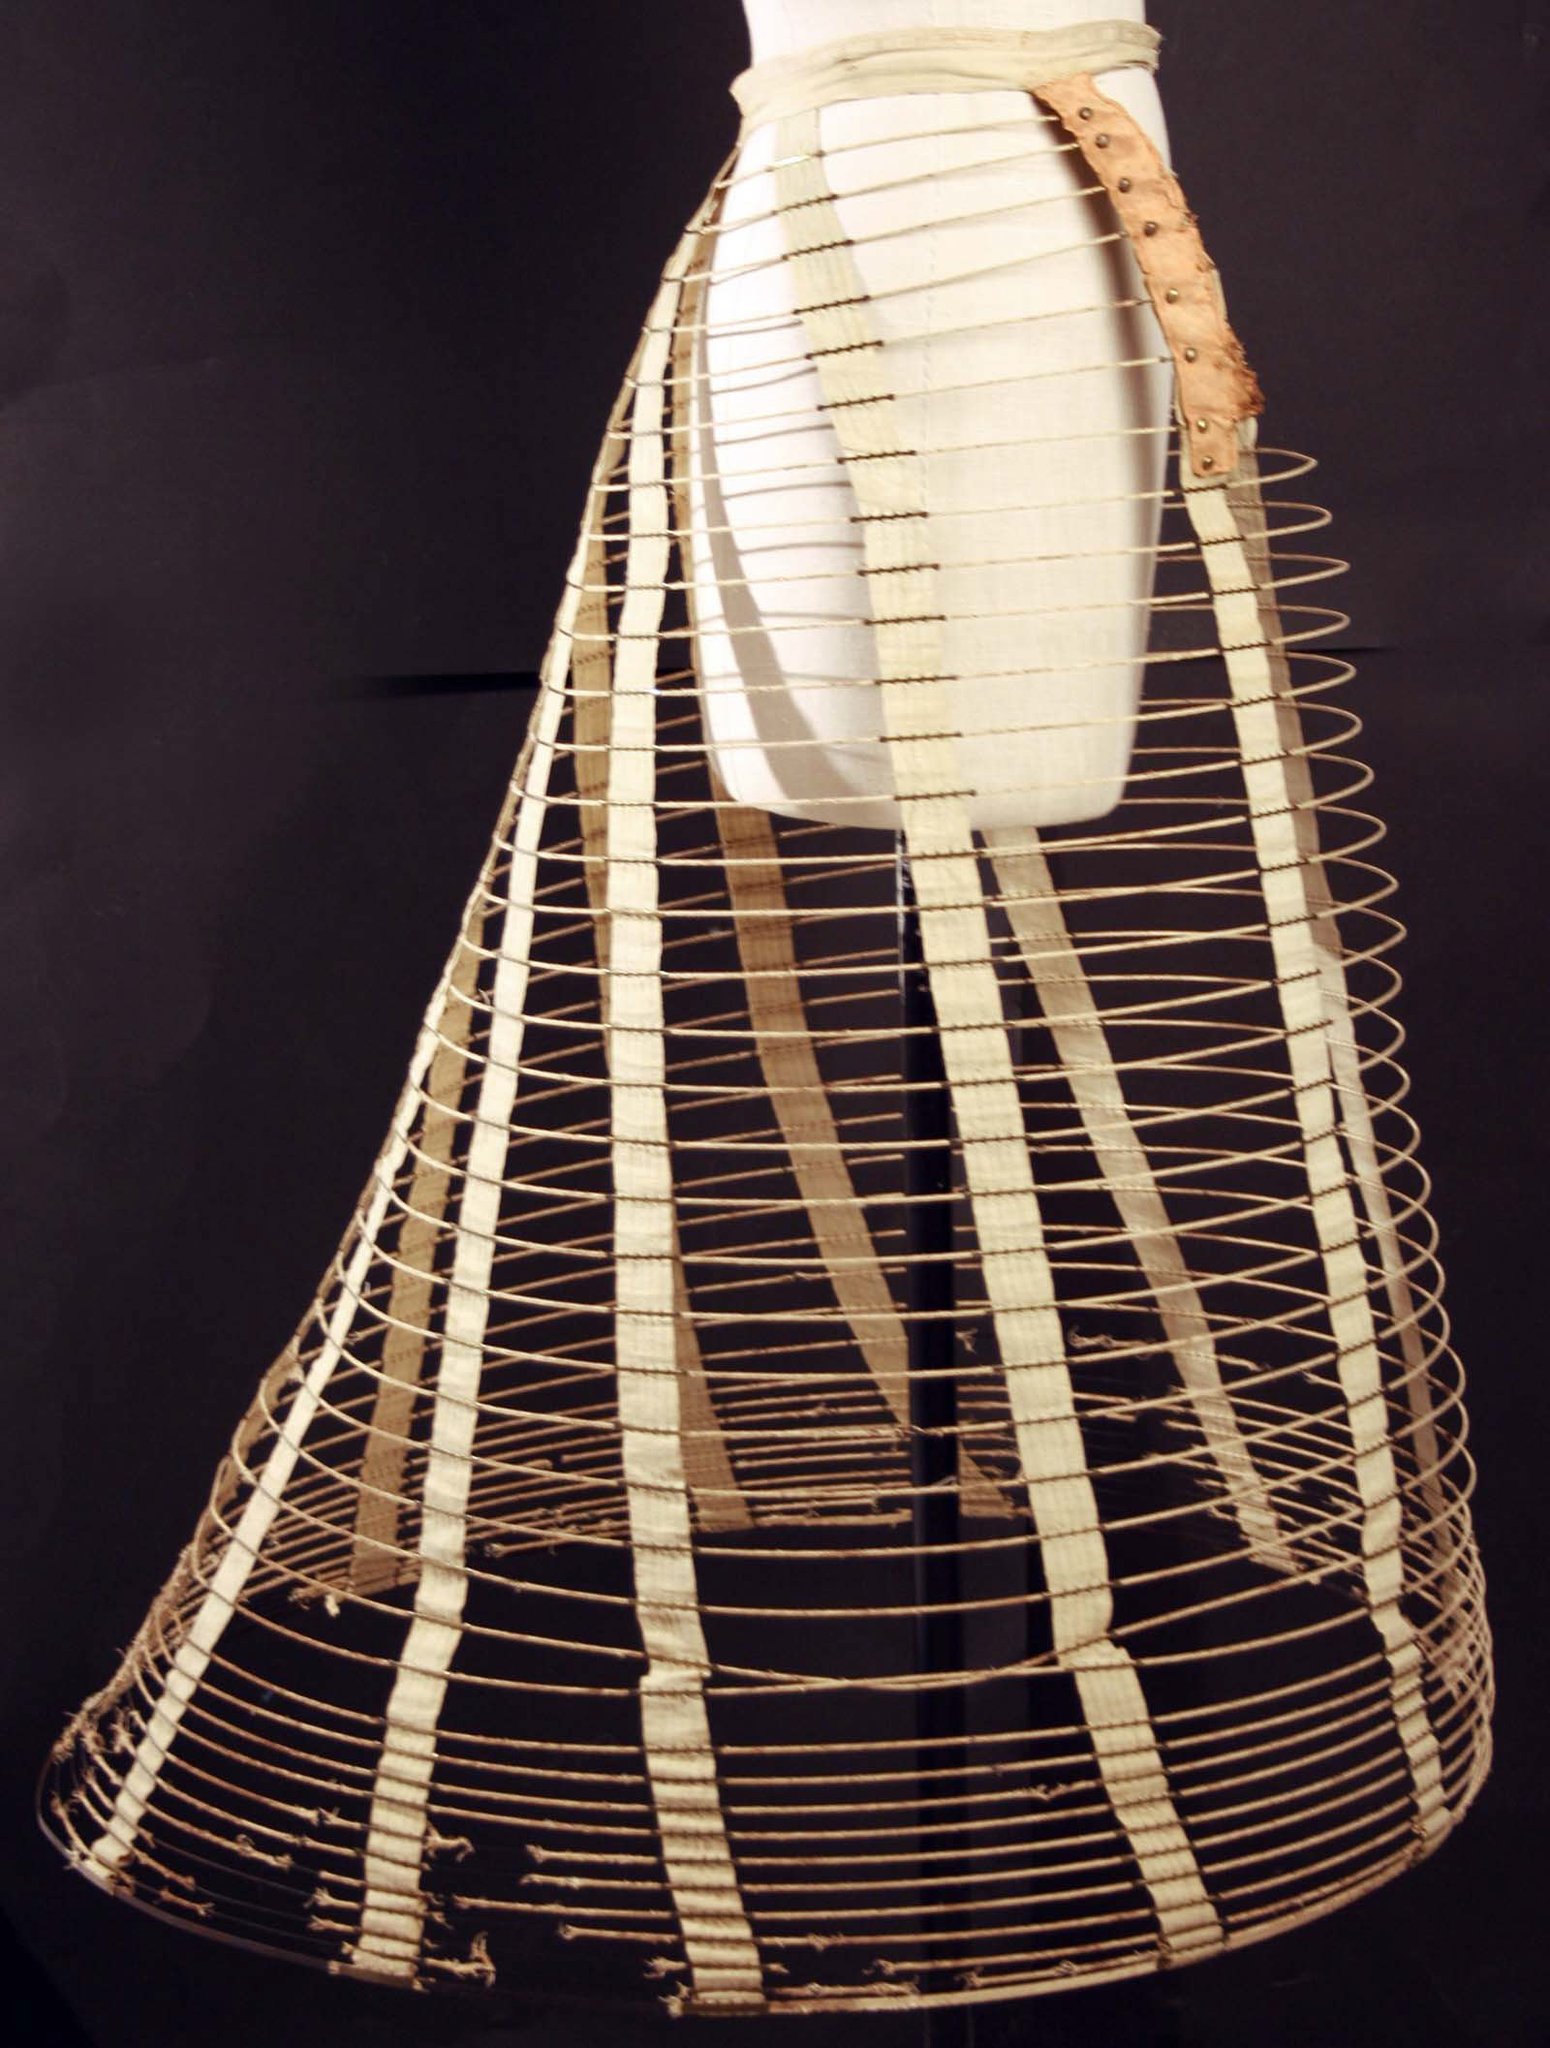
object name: hoop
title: Hoops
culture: american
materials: cotton, metal